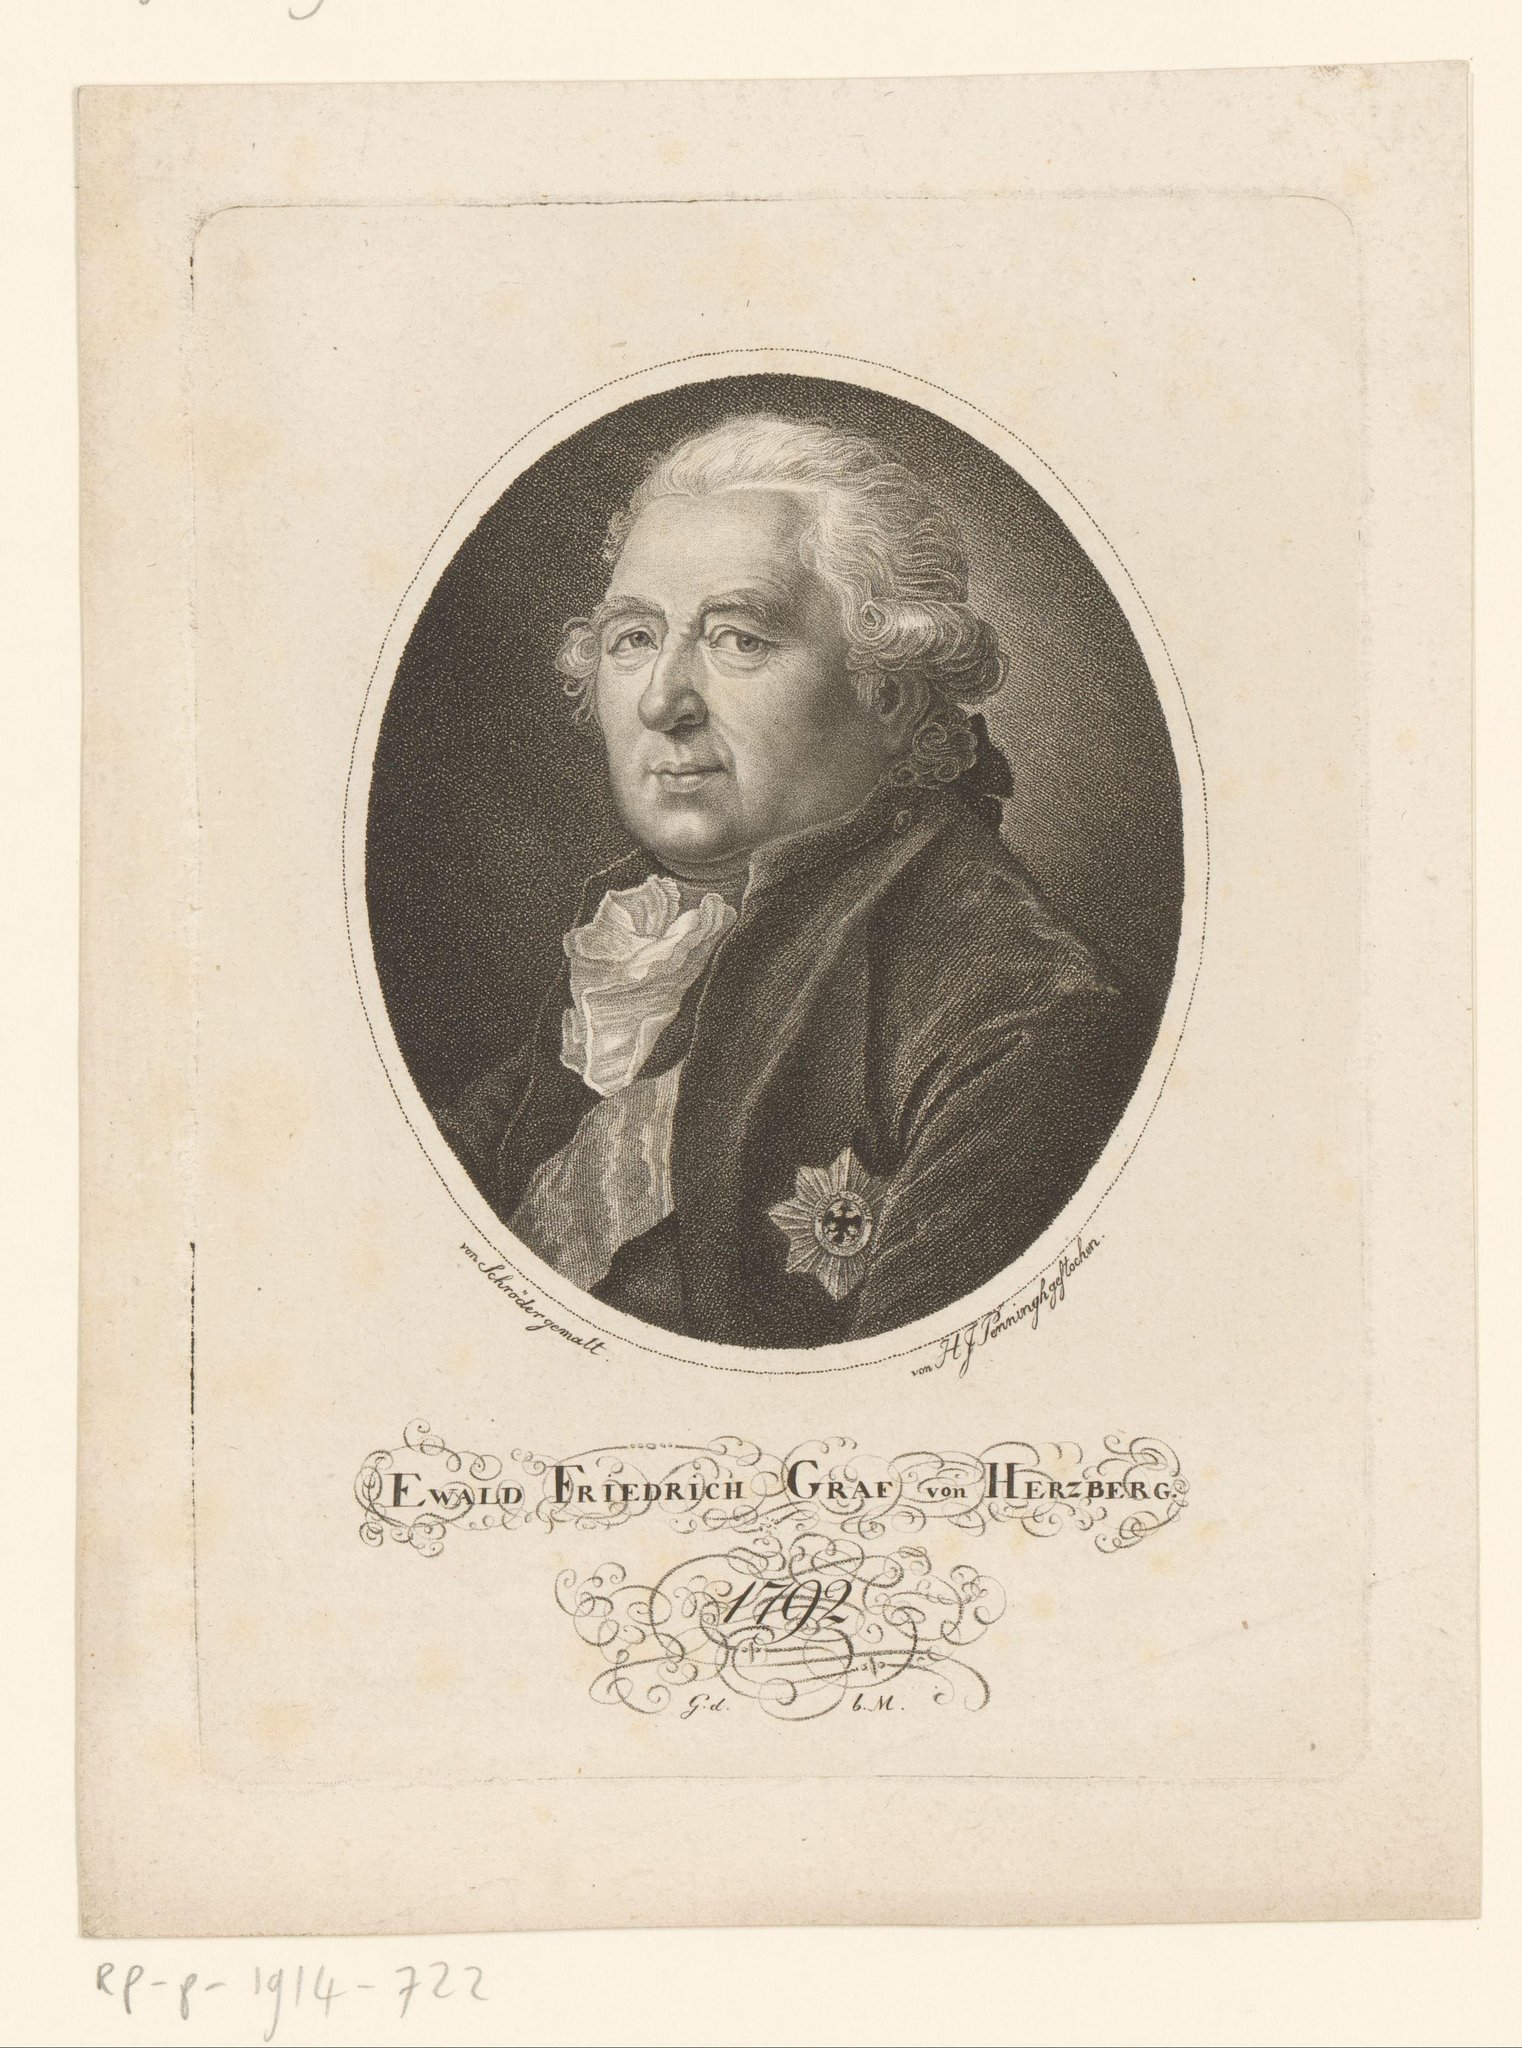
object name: print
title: Portret van Ewald Friedrich Graf von Hertzberg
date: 1792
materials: paper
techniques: engraving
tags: poland, berlin, ewald friedrich von hertzberg (graaf), knighthood order (red eagle order), historical persons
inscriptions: collector's mark: Lugt 2228